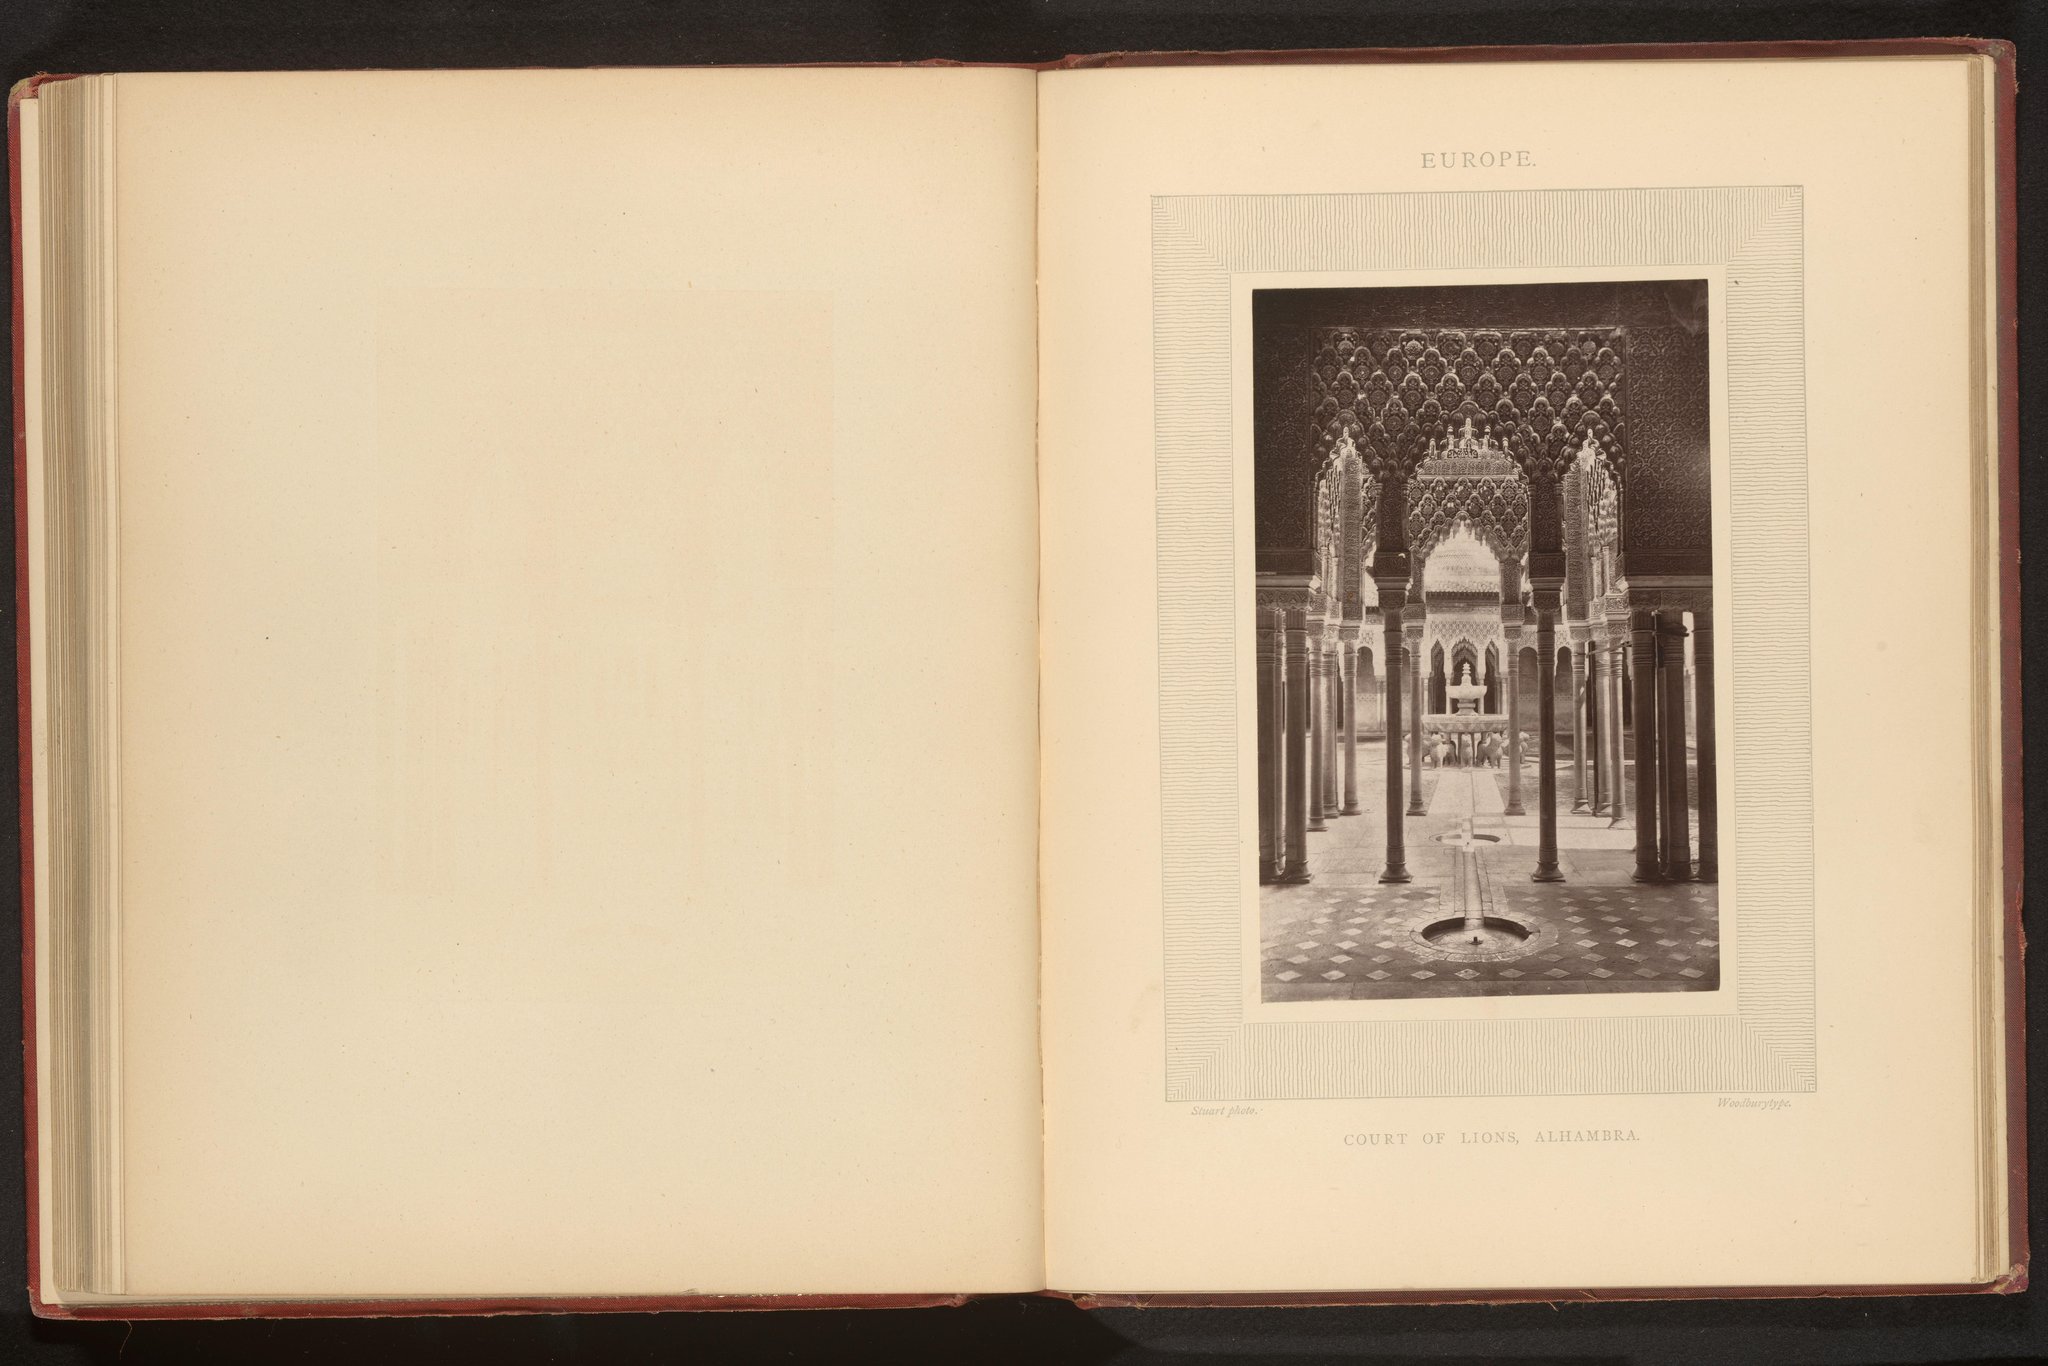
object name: page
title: Court of Lions, Alhambra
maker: Anonymous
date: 1870-1875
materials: cardboard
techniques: woodburytype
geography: alhambra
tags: column, pillar ~ architecture, courtyard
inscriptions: inscription: ‘Europe’, inscription: ‘Stuart photo.’